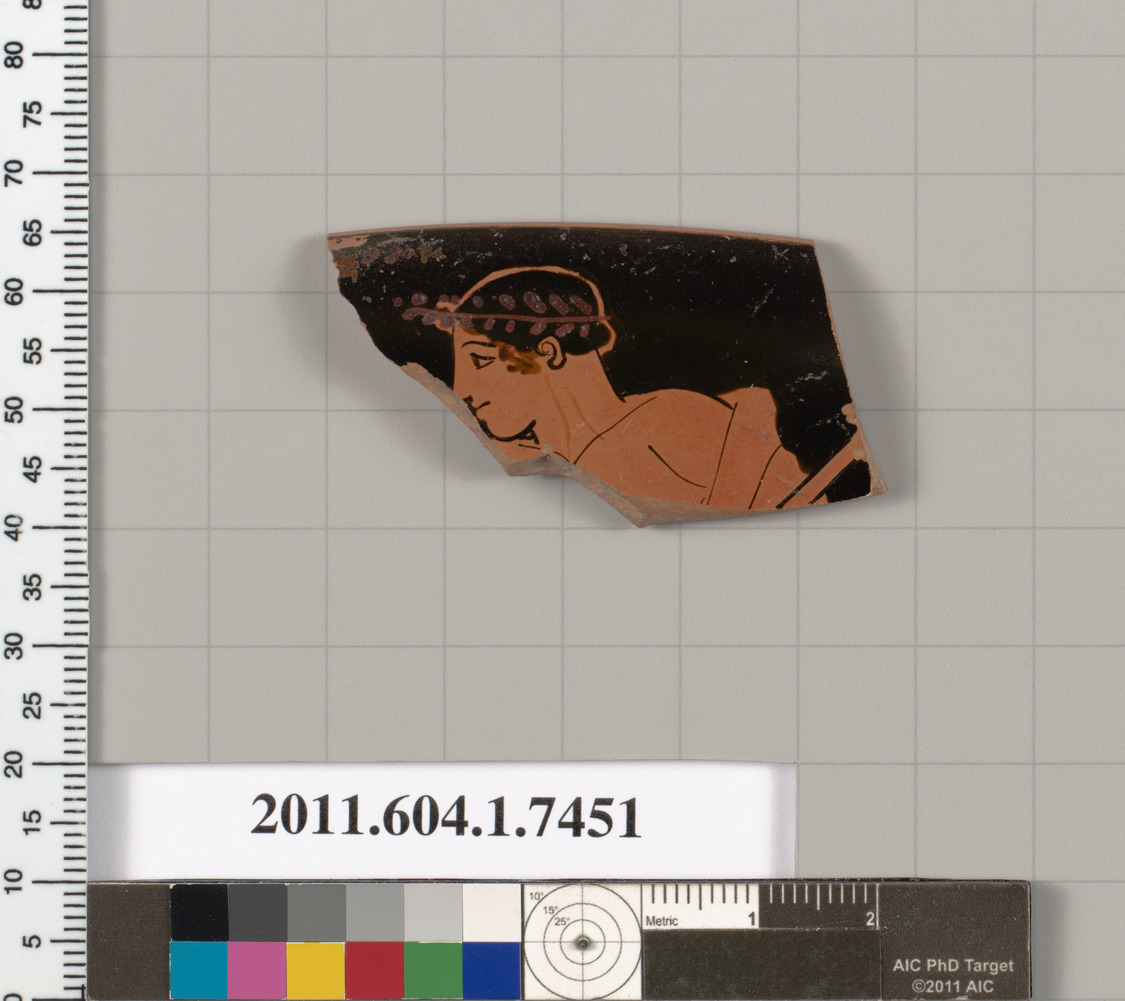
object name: kylix fragment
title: Terracotta rim fragment of a kylix (drinking cup)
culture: greek, attic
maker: hermonax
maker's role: artist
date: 470-460 BCE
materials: terracotta